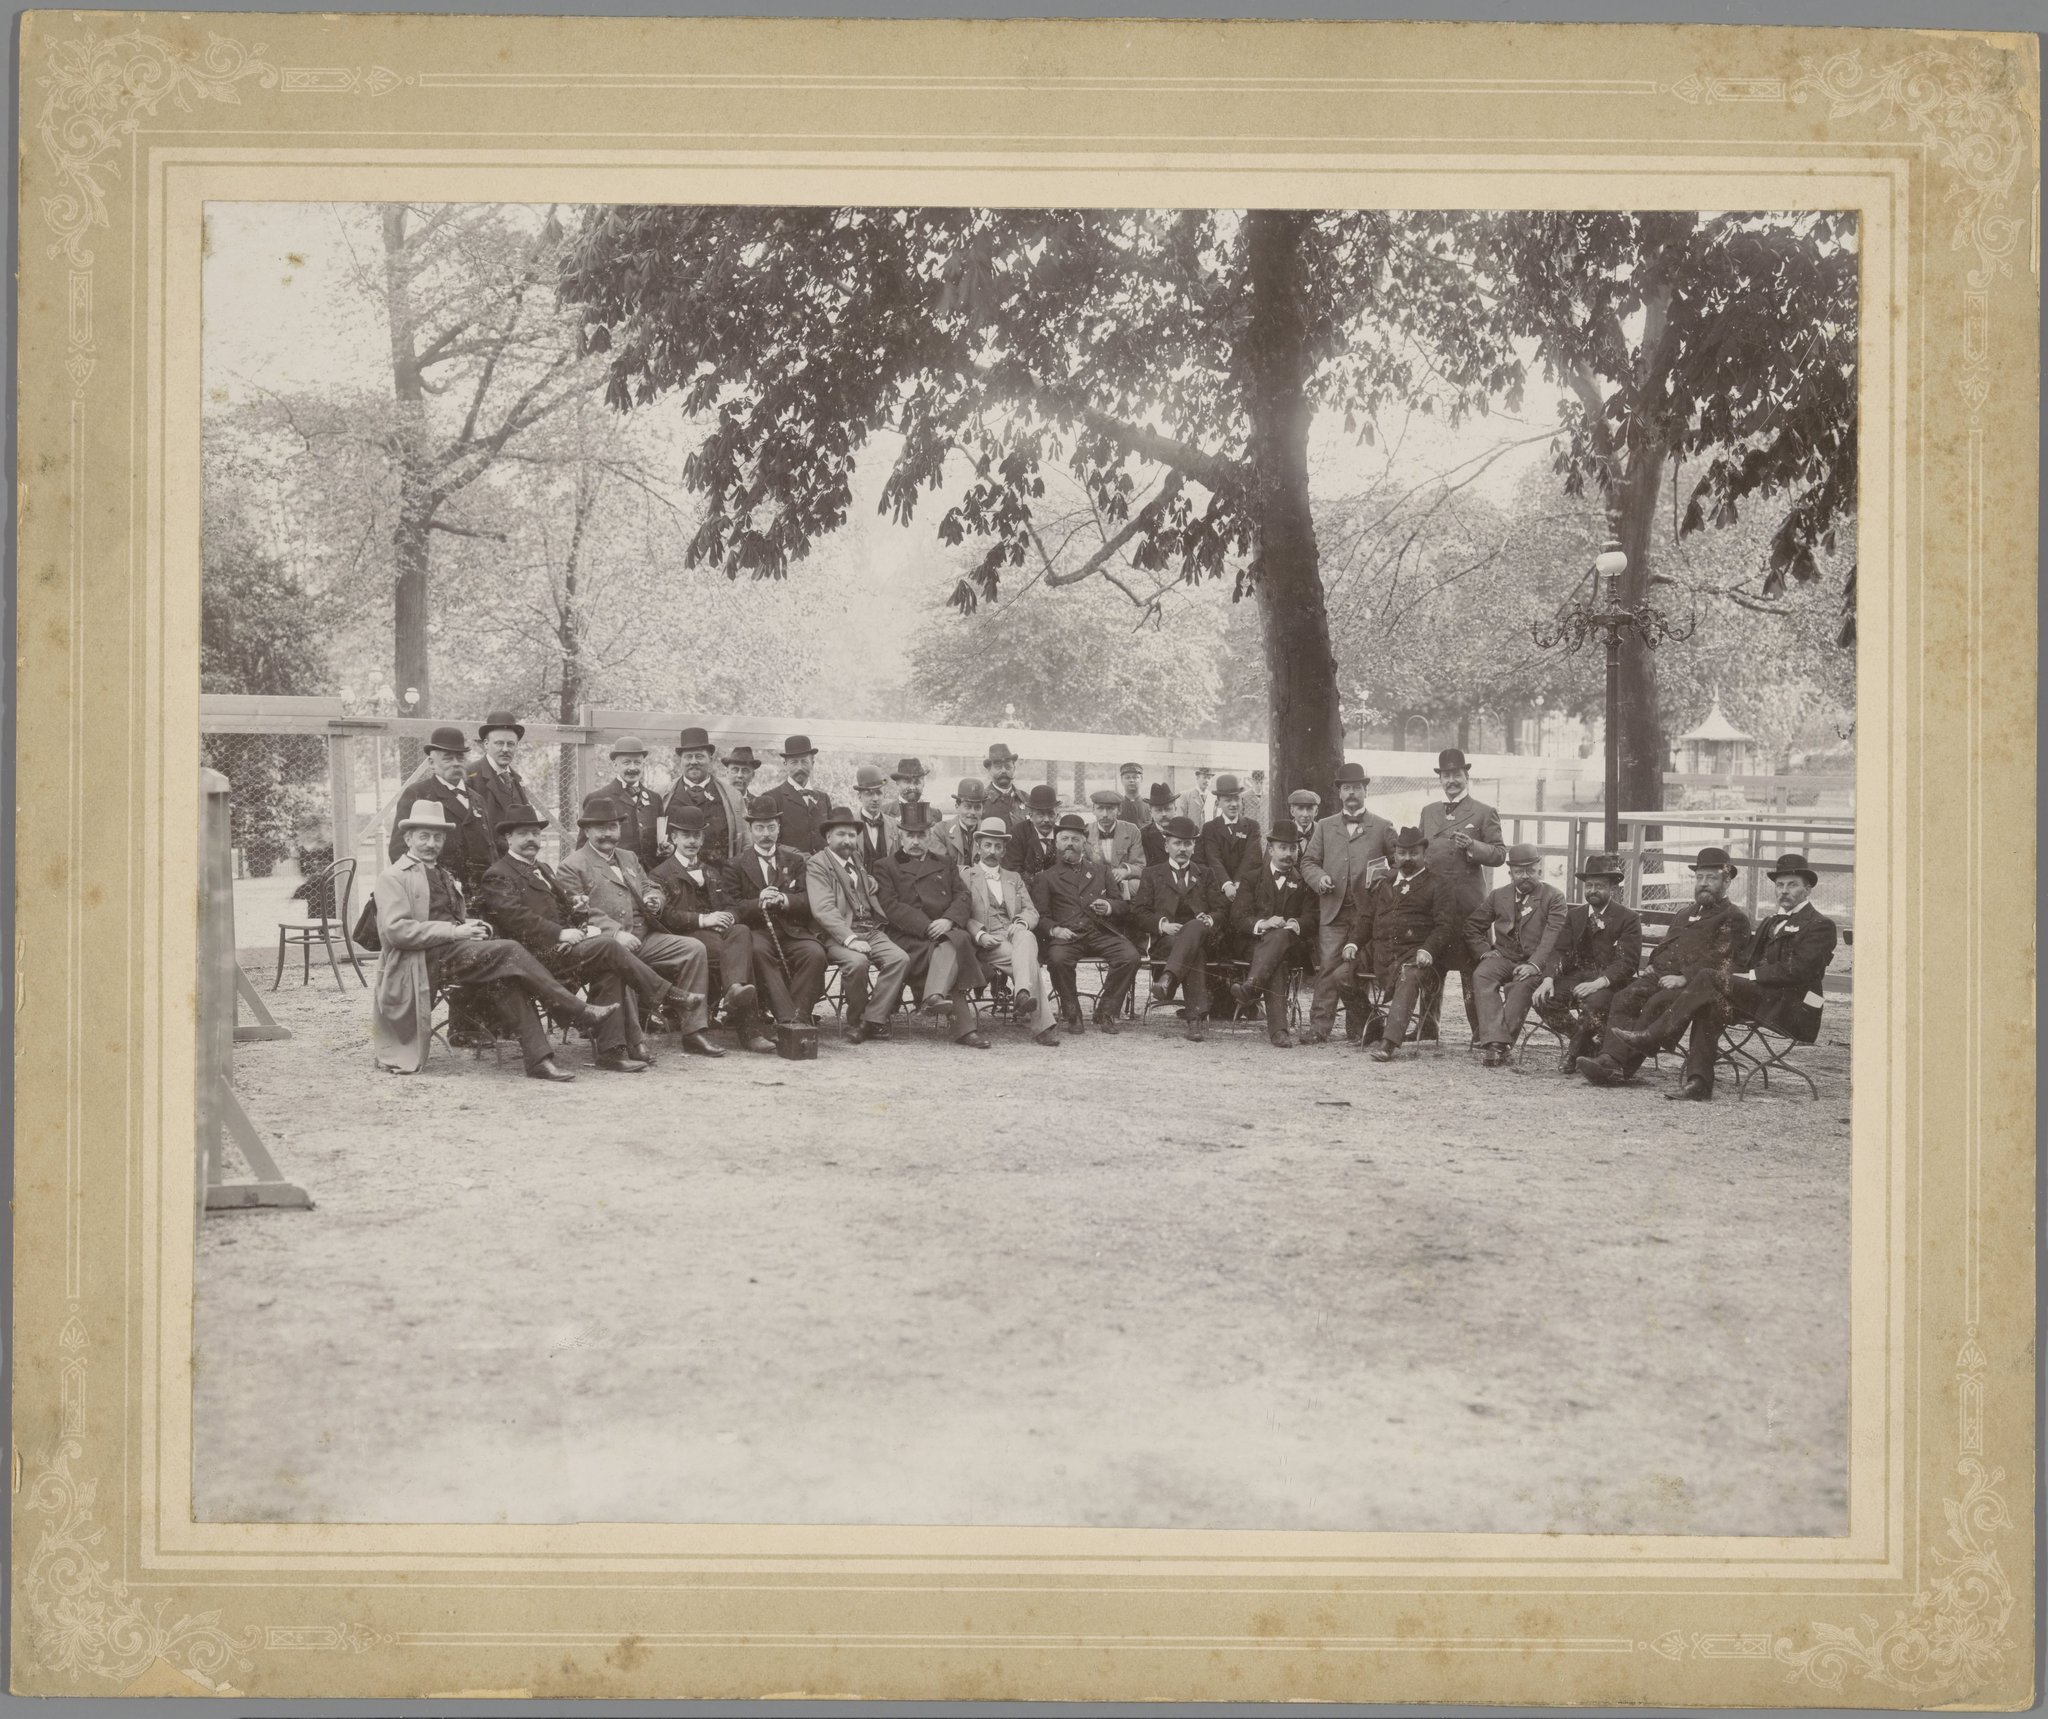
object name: photograph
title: Groepsportret van mannen met bolhoeden op tuinstoelen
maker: Anonymous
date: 1890-1920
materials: cardboard, photographic support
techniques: gelatin silver print